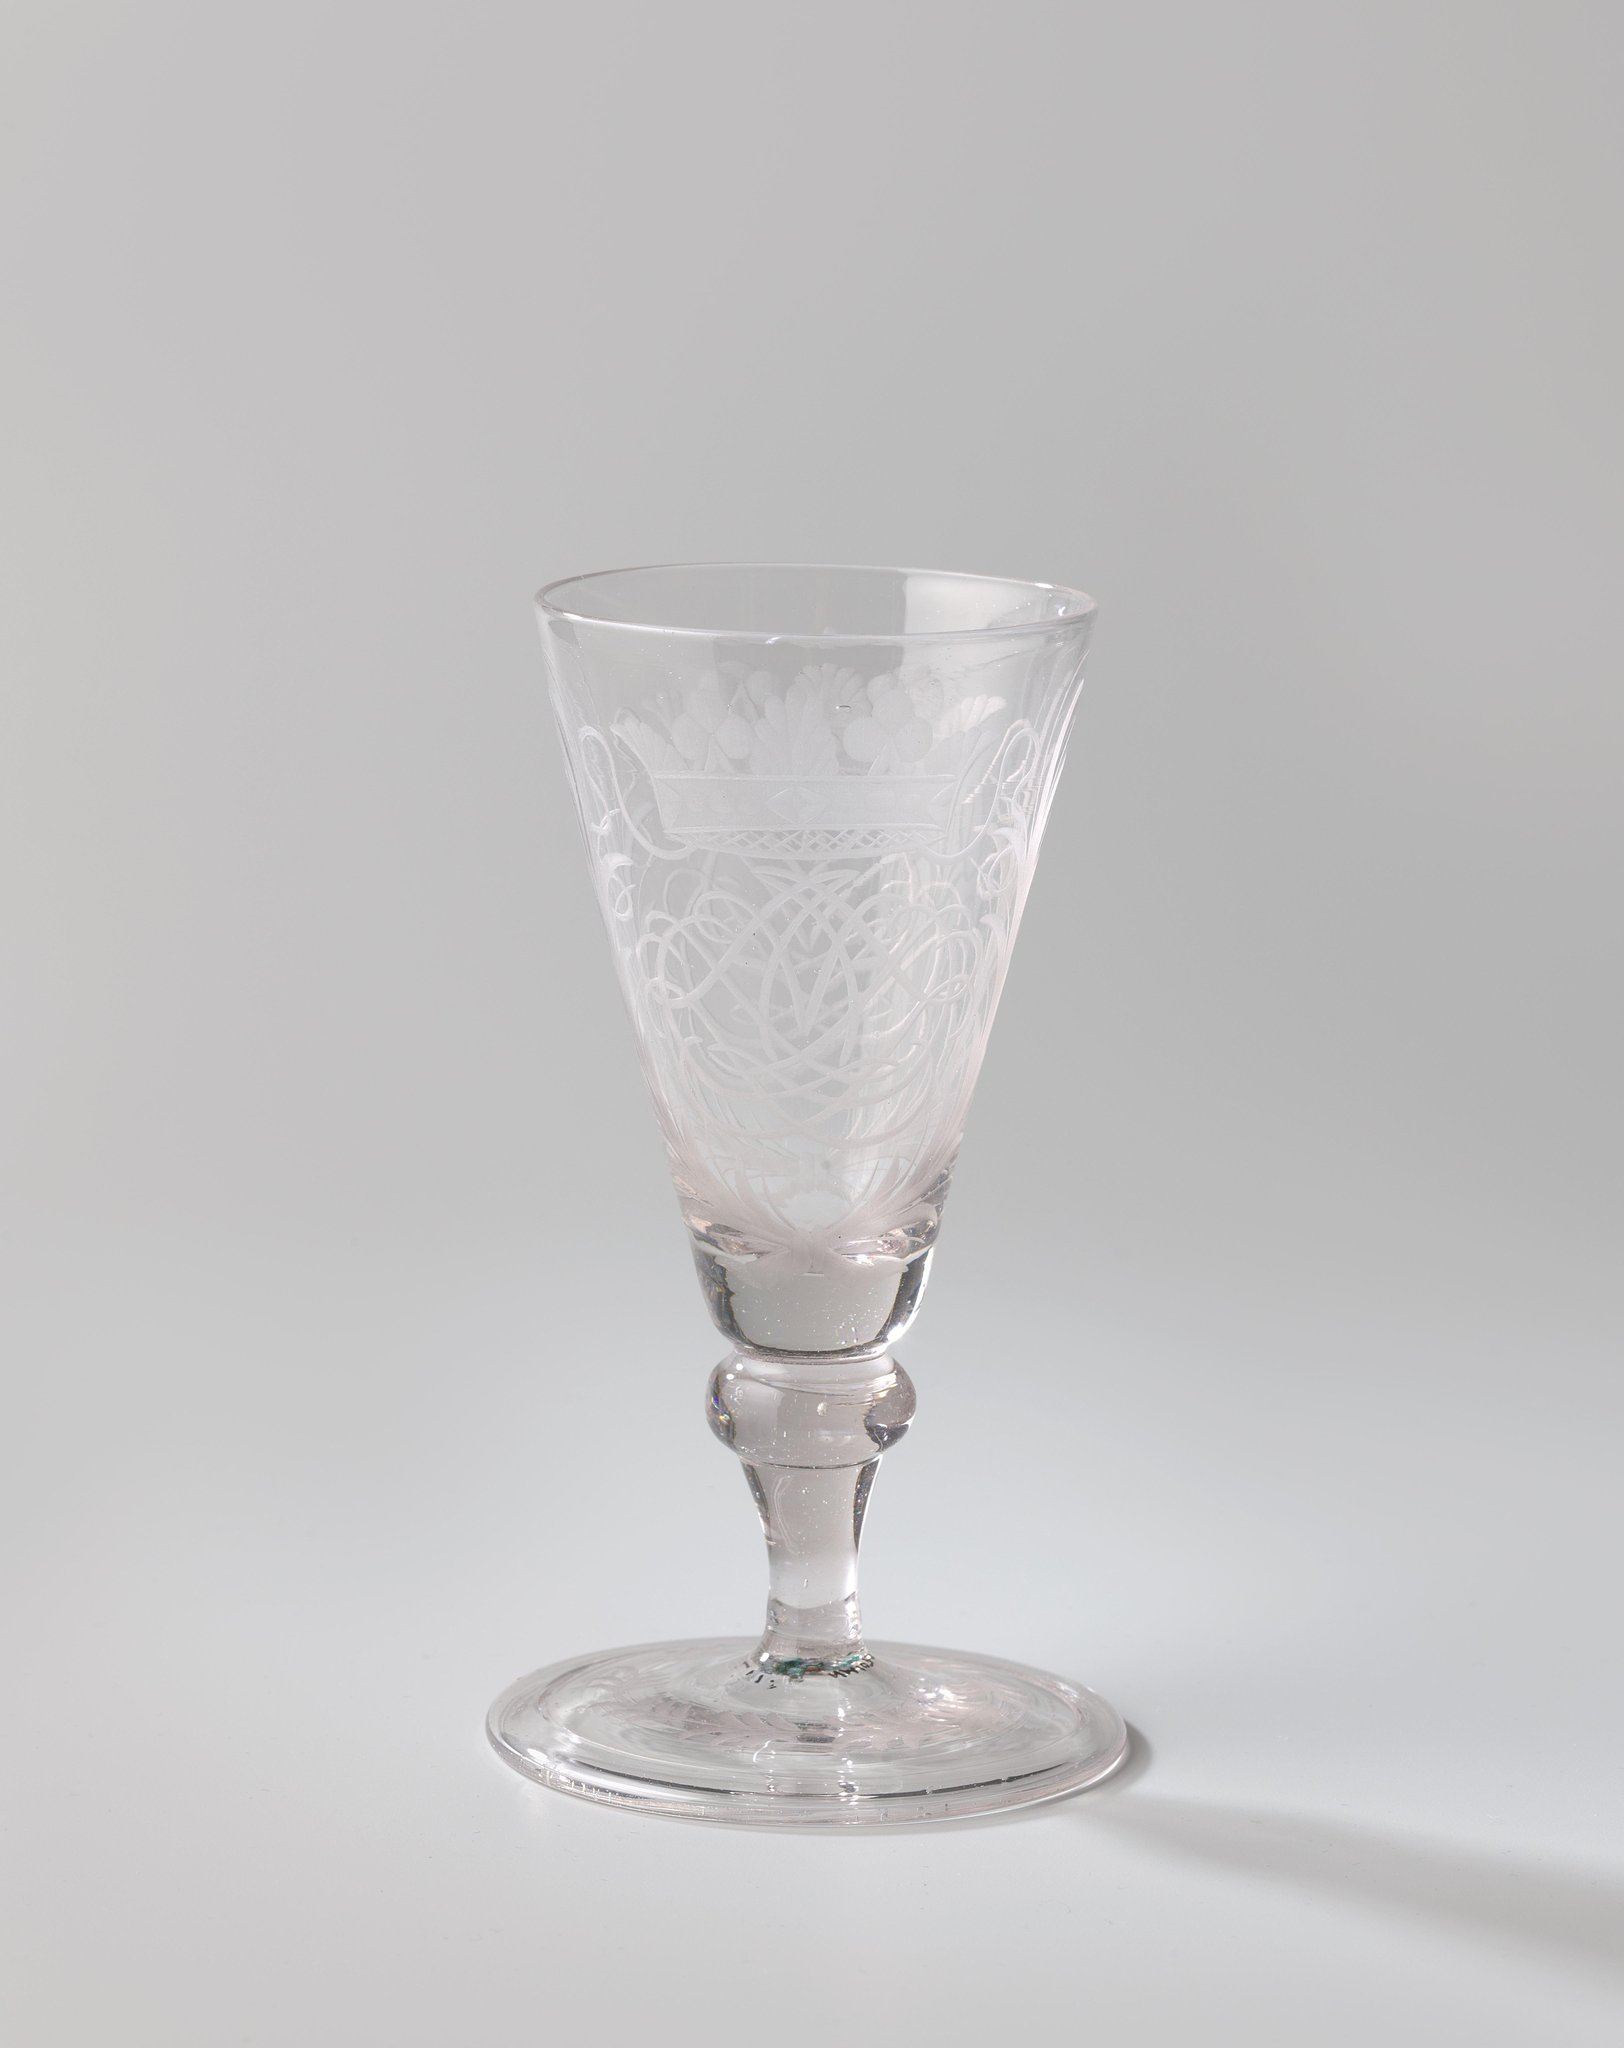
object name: goblet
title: Kelkglas met tweemaal het gekroonde monogram AVA tussen palmtakken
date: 1700-1725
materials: glass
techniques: glassblowing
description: Kelkglas met hoge kelk en korte balusterstam. Op de kelk twee maal hetzelfde gekroonde monogram AVA tussen palmtakken. Op de voet een bladkrans.